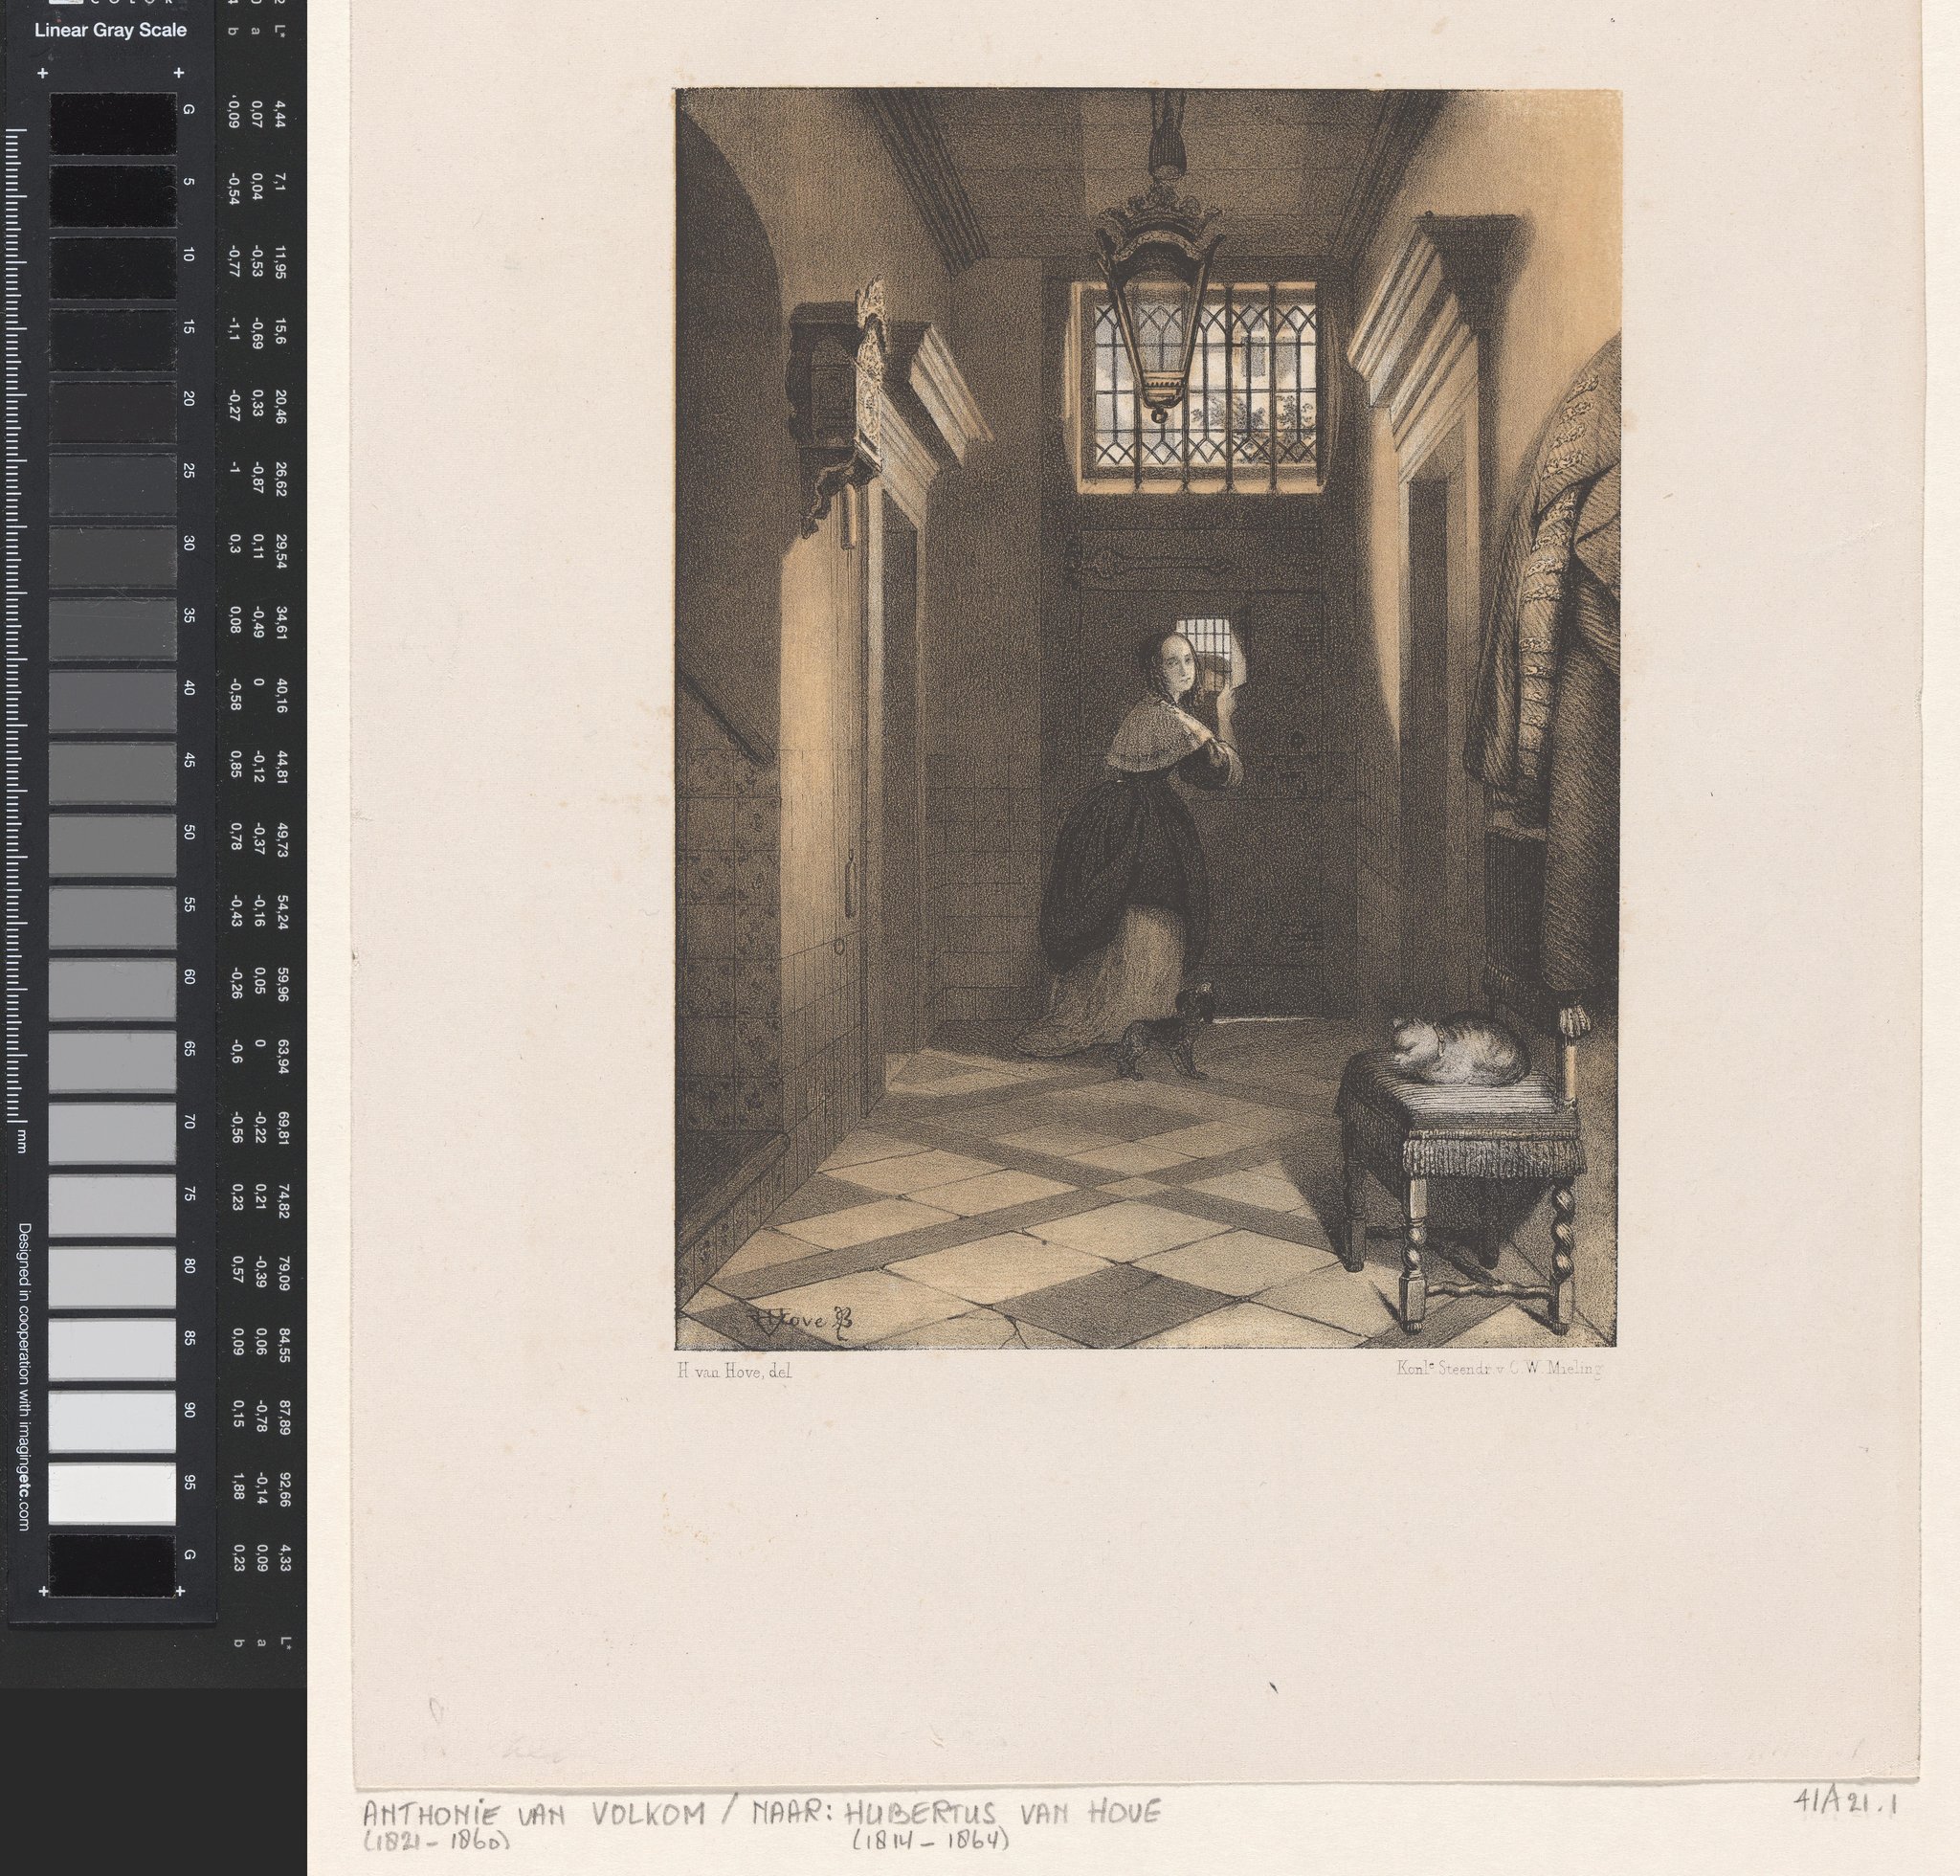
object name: print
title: Vrouw opent voordeurluik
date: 1850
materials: paper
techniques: tone lithography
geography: the hague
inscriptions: collector's mark: Lugt 2228, stamp: ‘Waller’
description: Een vrouw opent het luik van een voordeur. Bij haar staat een hond. Op de voorgrond ligt een kat op een stoel.